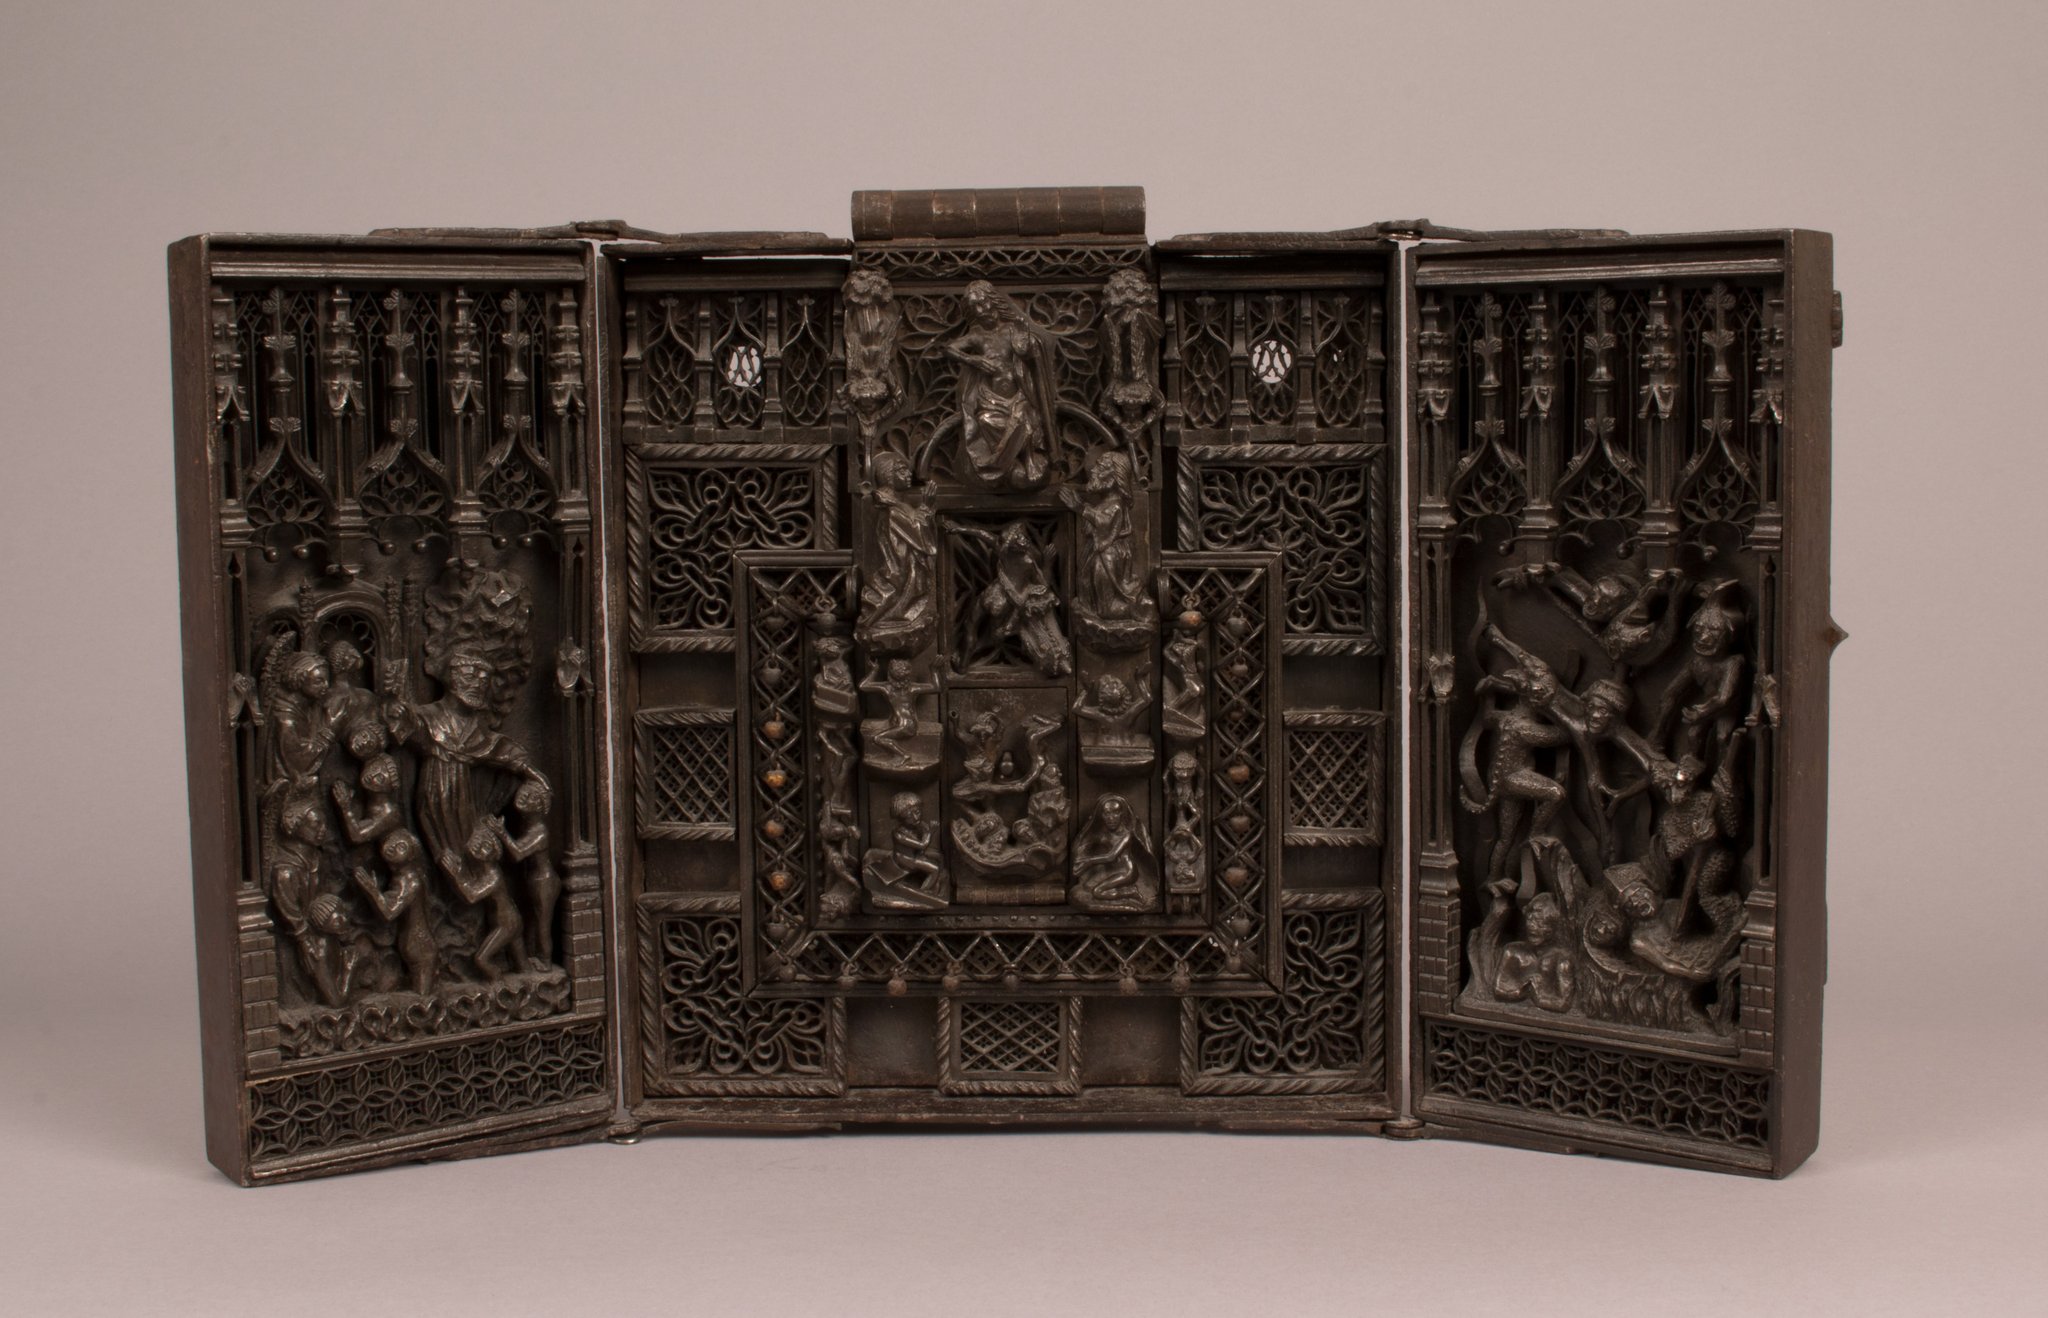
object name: lock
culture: french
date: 1401-1500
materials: copper alloy, iron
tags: christ,saint peter,virgin mary,demons,last judgement